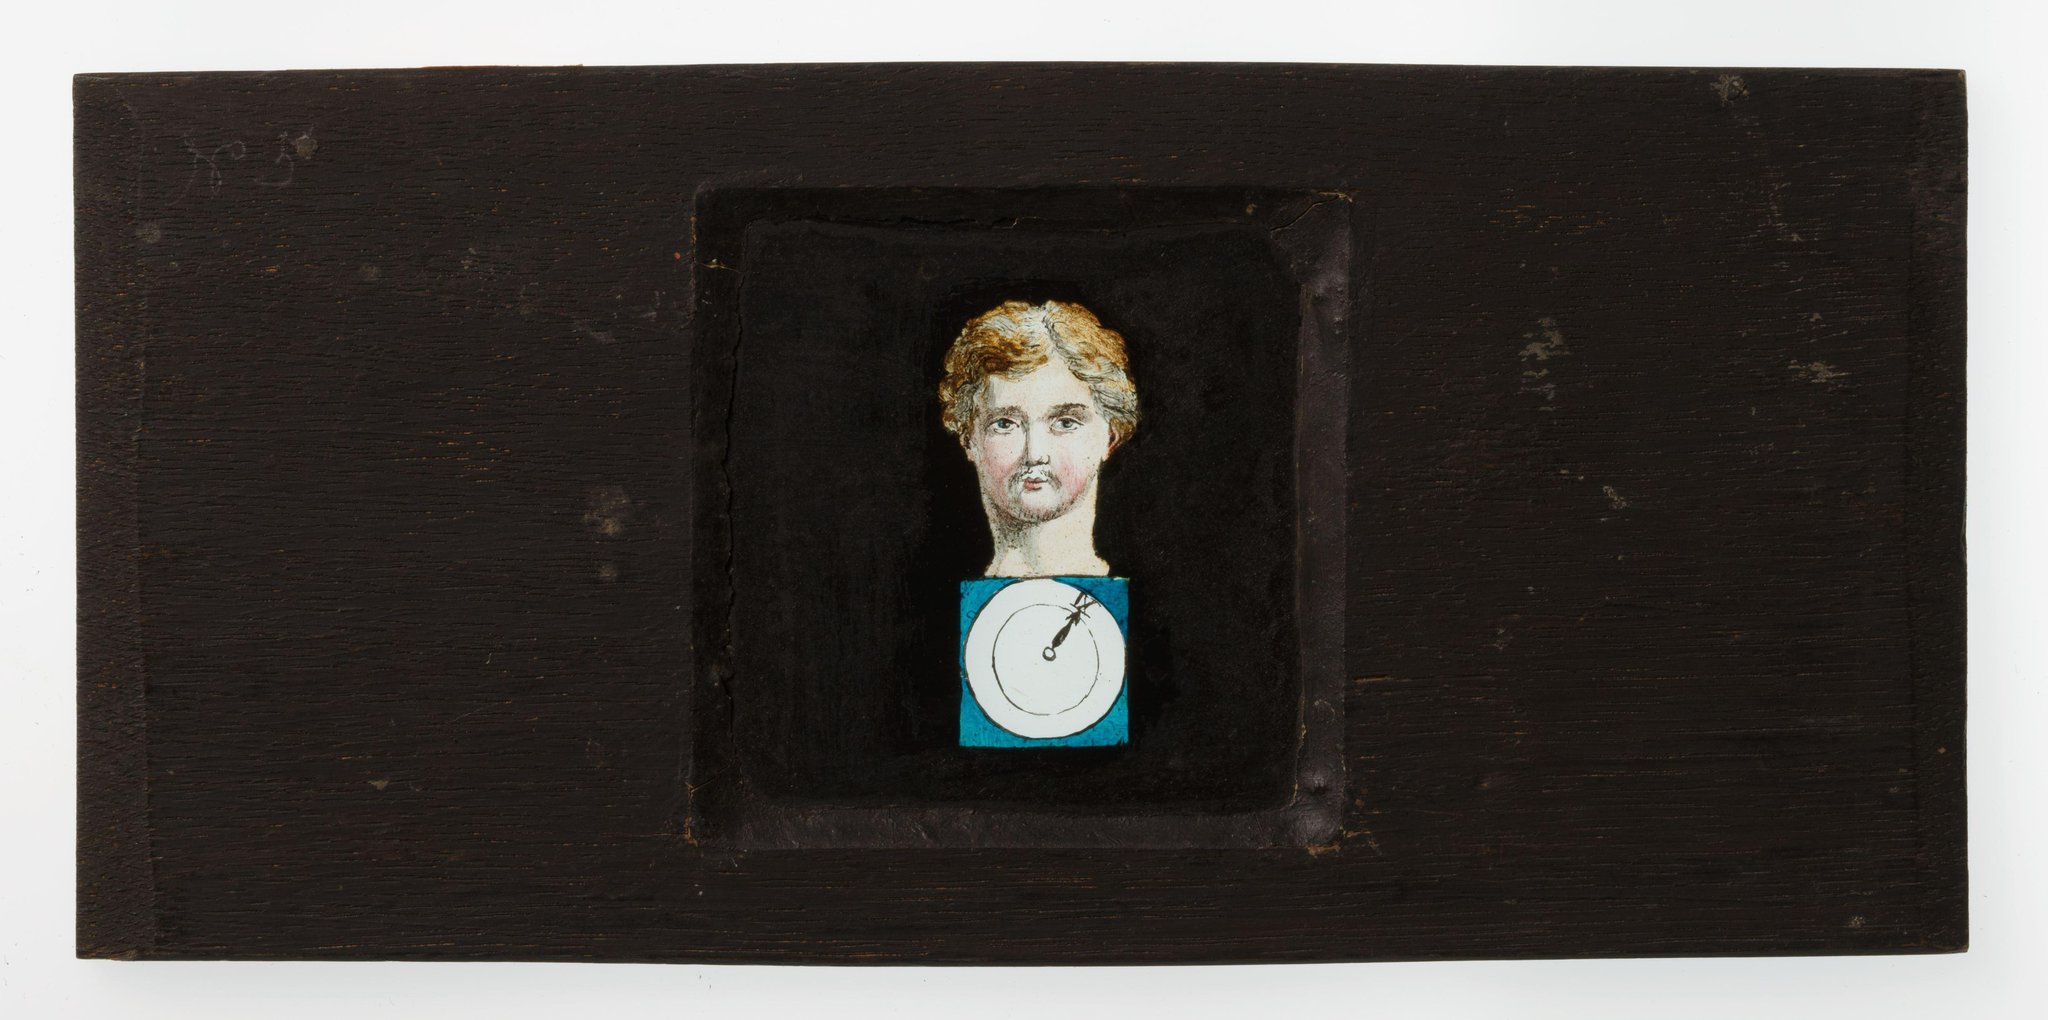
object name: lantern slide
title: levensfasen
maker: Anonymous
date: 1790-1830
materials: glass, wood, oil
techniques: painted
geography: france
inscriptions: label: ‘'Gebrandschilderde glazen. Collectie I.S. van der Schaaff, Baarn. Nummer 47 (zevenenveertig) bevattende één glas, voorstellende de buste eens jongeman, waaronder een uurwijzerplaat. Het glas is geheel ongeschonden en gaaf op 13 april 1886.'’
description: Vierkante glasplaat in houten vatting. Buste van een jongeman met beginnende baardgroei. Daaronder een klok die op met gesloten ogen. Daaronder een klok die op elf uur staat. Onderdeel van een serie bustes met klokken die de fasen van het leven verbeelden.